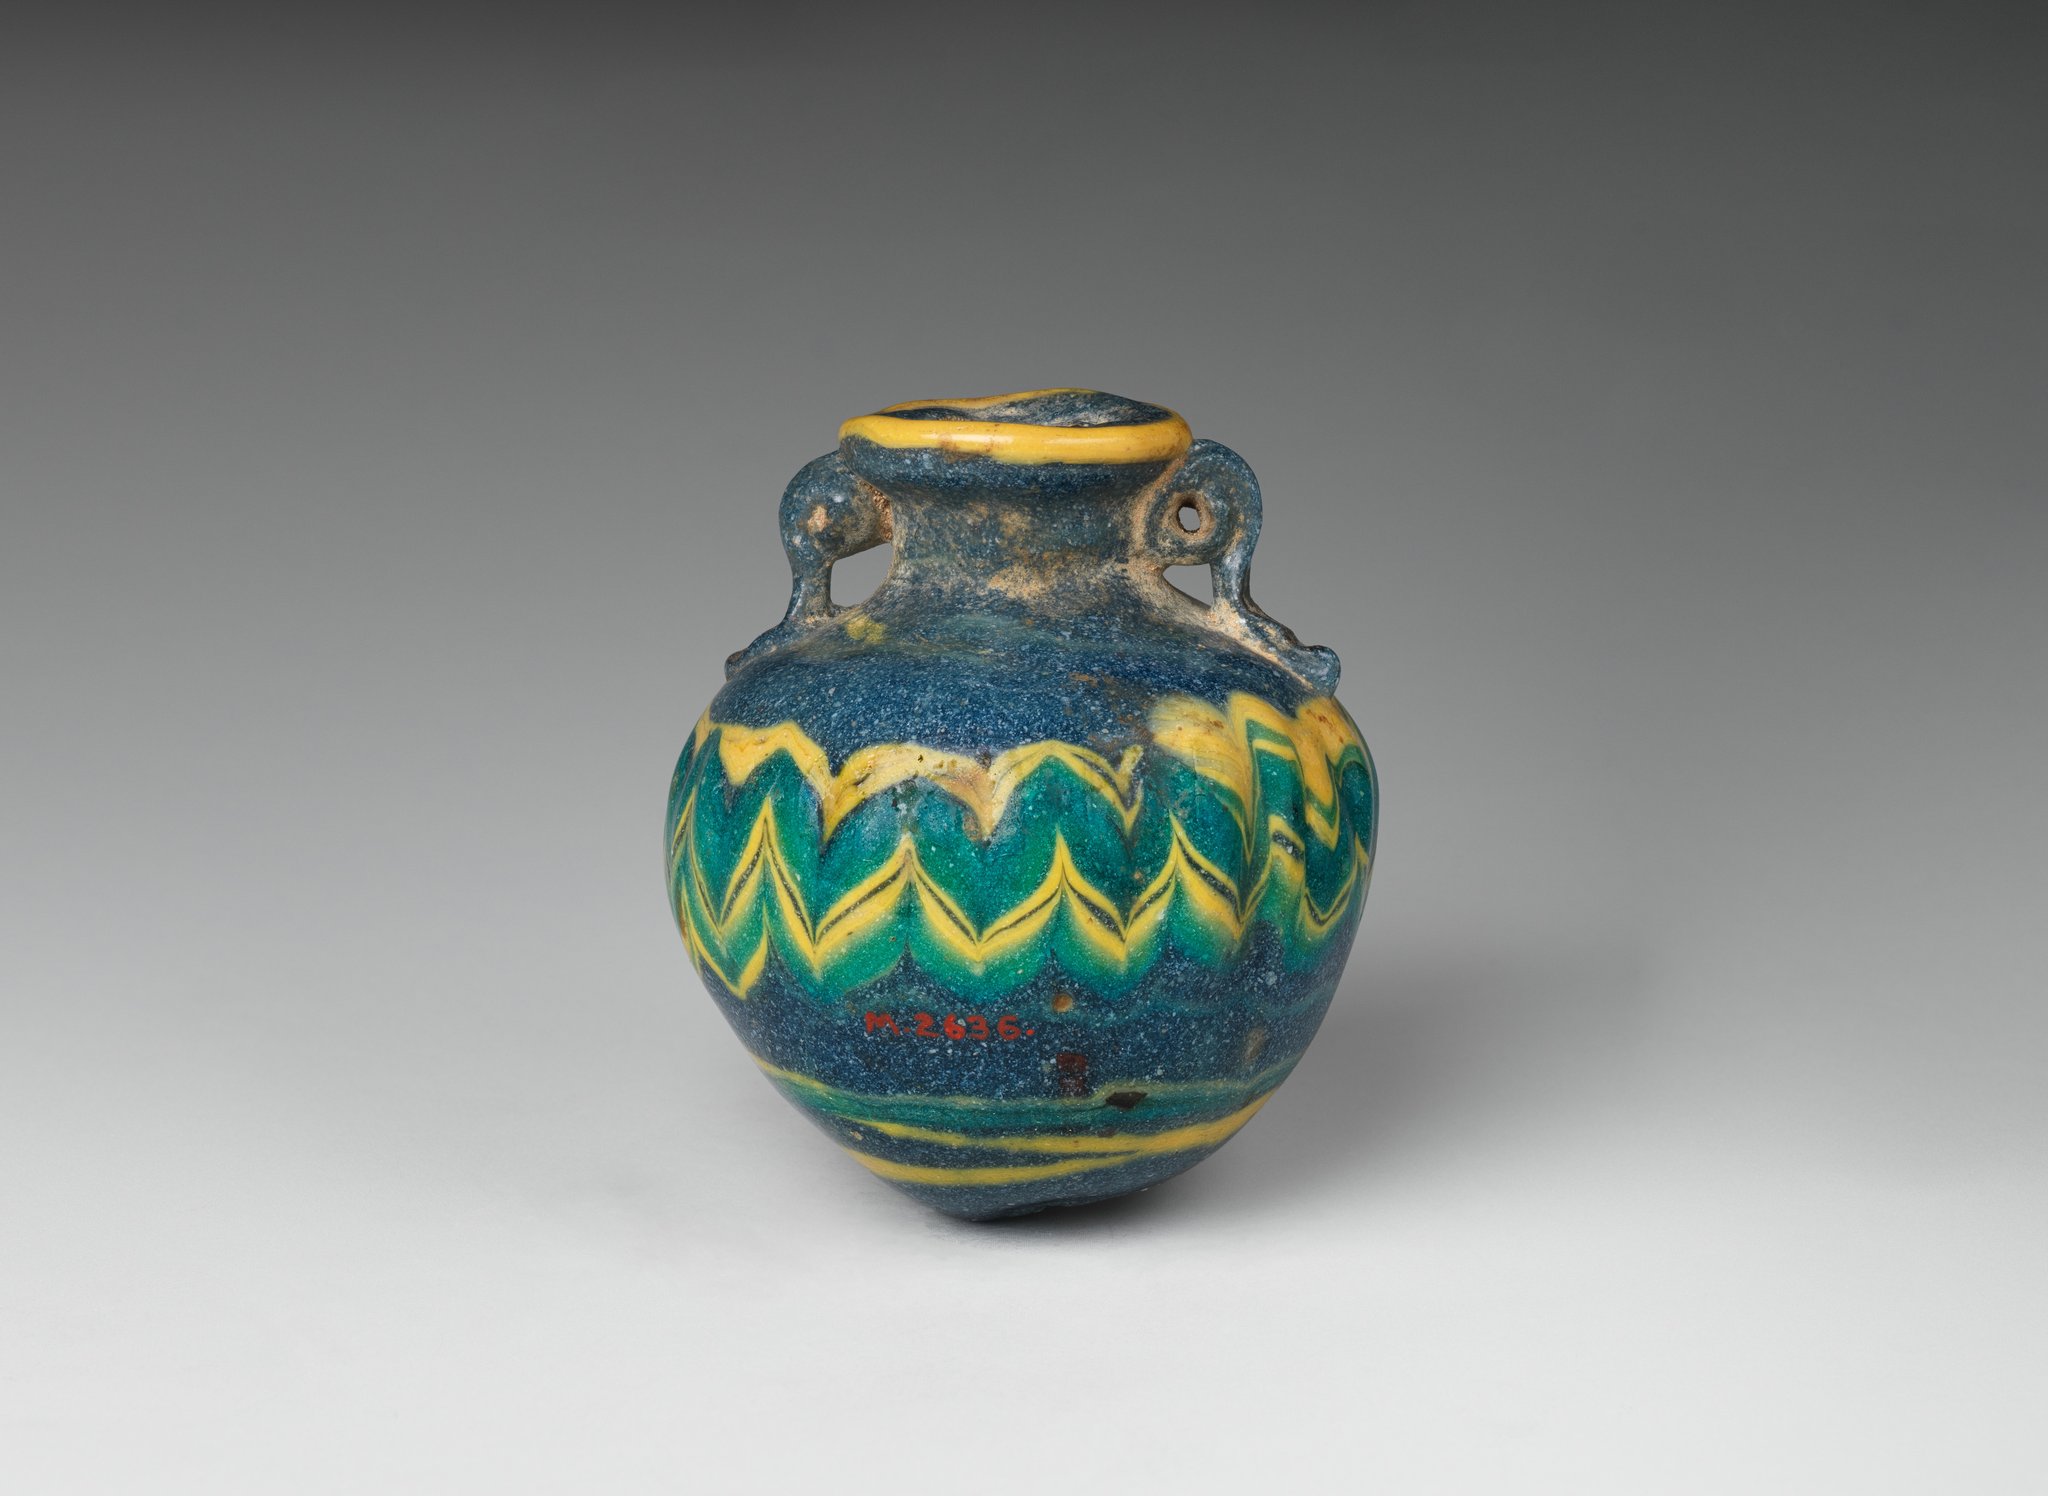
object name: vase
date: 664-332 BCE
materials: glass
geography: egypt